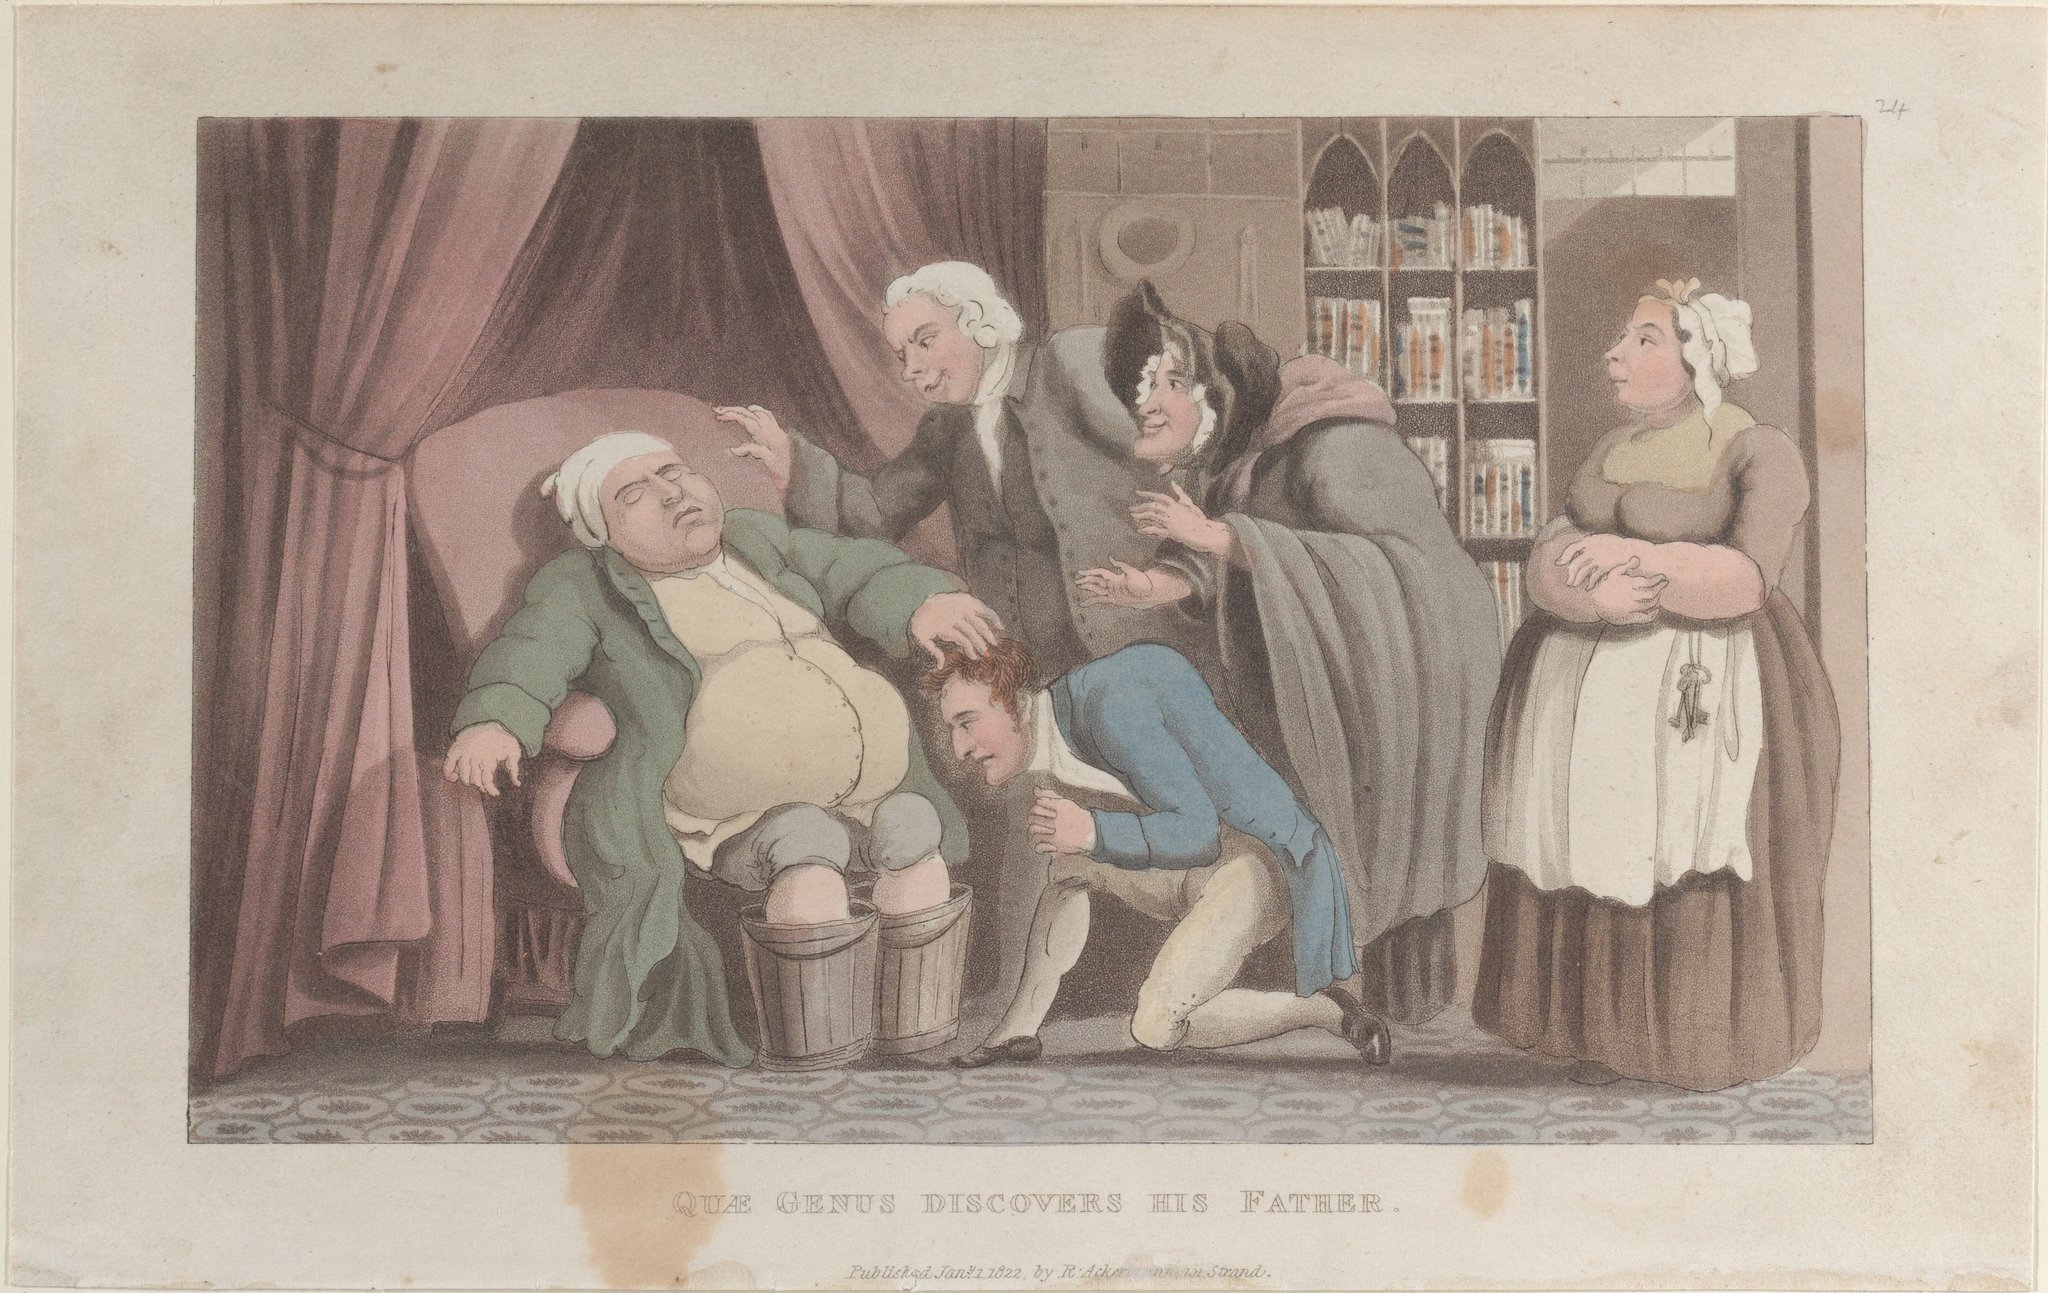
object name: print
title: Quae Genus Discovers His Father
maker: thomas rowlandson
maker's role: artist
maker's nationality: british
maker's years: 1757-1827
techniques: aquatint, etching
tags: men,women